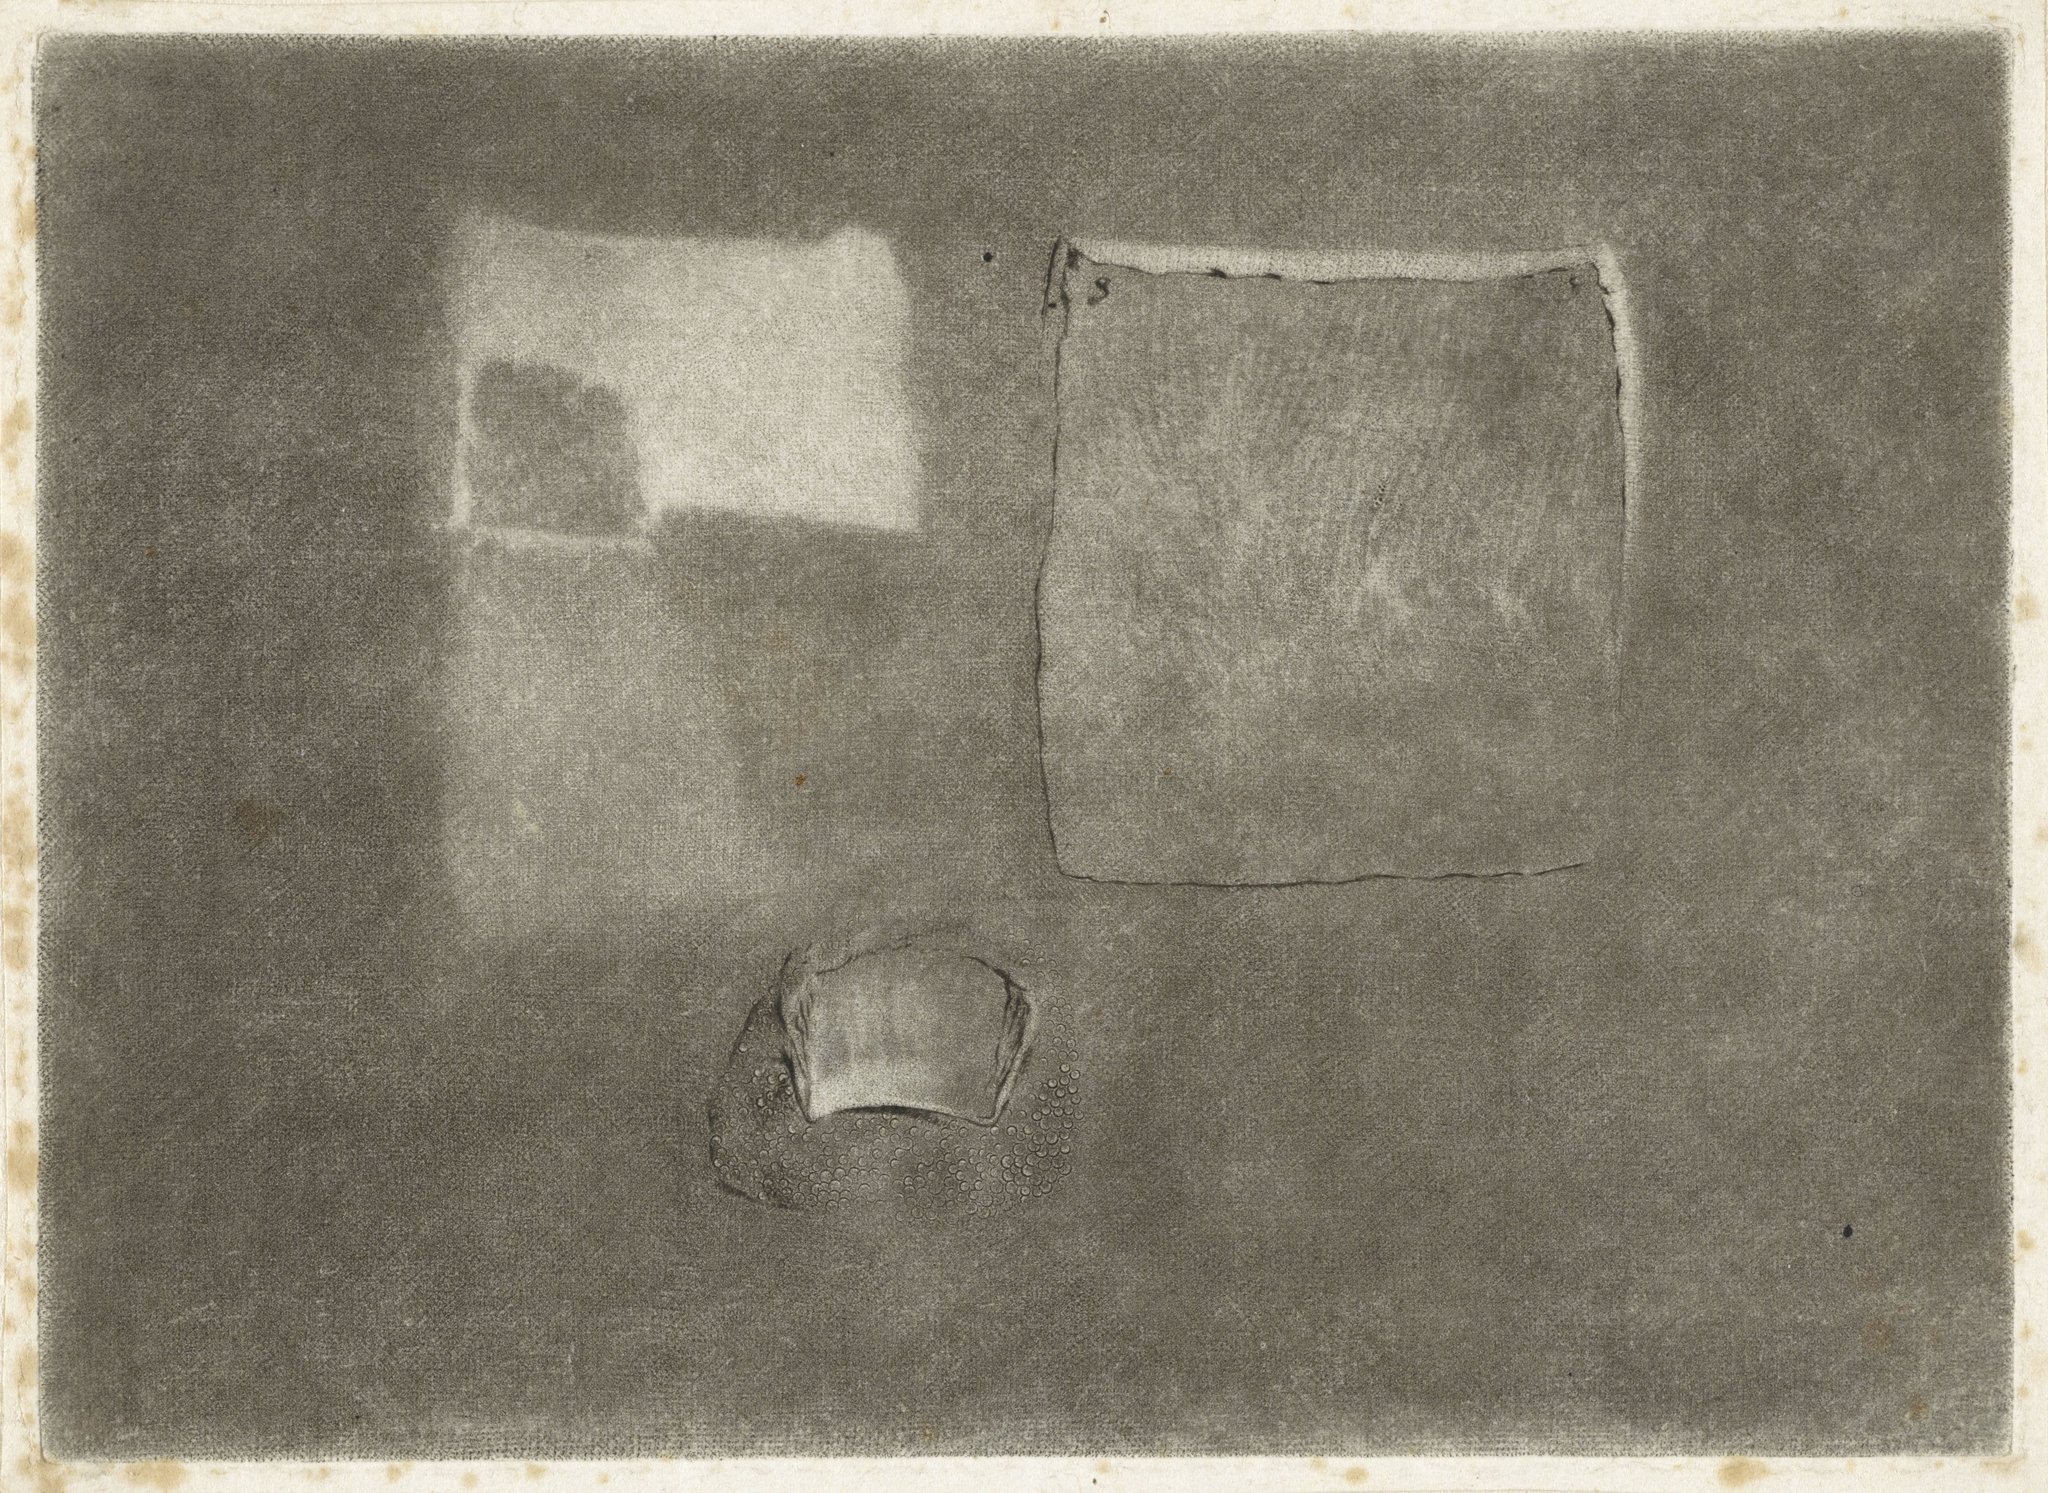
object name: print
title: Anatomische studie van menselijke huid en nagel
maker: jan l admiral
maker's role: draughtsman, print maker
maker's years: 1699-1773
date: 1737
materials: paper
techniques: etching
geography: amsterdam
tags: other anatomical details, skin (human), nails (fingers)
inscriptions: collector's mark: Lugt 2233, collector's mark: Lugt 2228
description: Jan L'Admiral gebruikte voor de groep mezzotinten met het onderwerp 'Anatomische studie van menselijke huid en nagel' vier verschillende platen: A, B, C en D. Proefdruk voor illustratie in: Albinus, Bernhard Siegfried. Dissertatio secunda. De sede et caussa coloris Aethiopum et caeterorum hominum, Leiden: Dirk Haak (II) en Amsterdam: Jacob Graal en Hendrik de Leth, 1737.